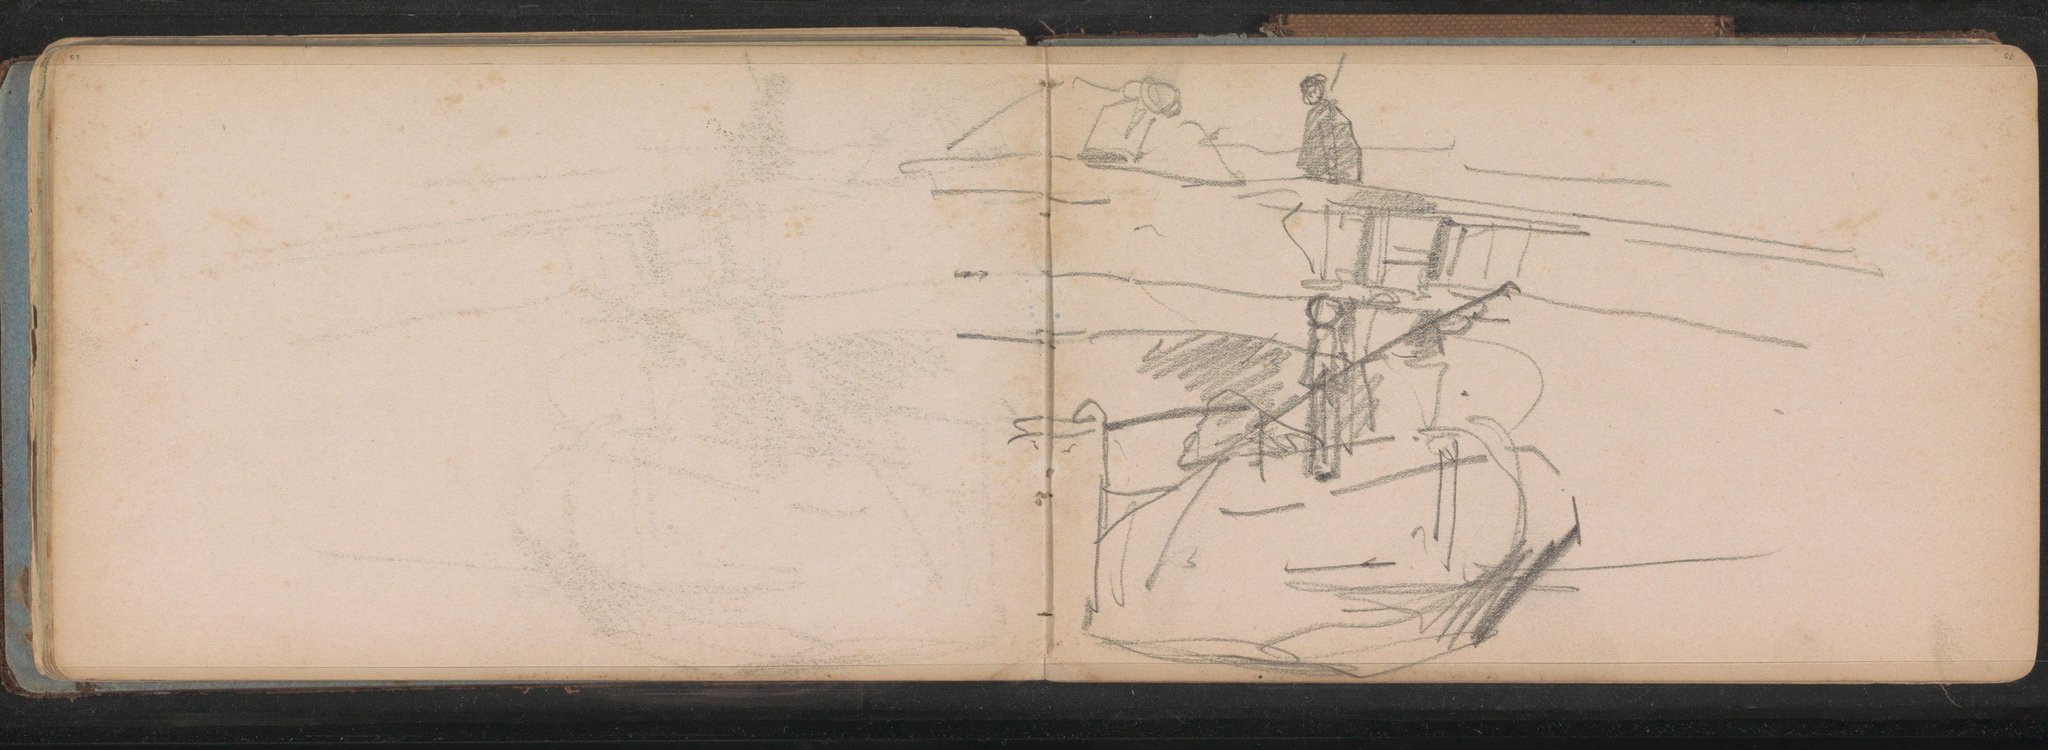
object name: sketchbook leaf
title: Figuur, mogelijk bij een schip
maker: george hendrik breitner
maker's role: draughtsman, painter, print maker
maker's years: 1857-1923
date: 1880-1882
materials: paper, pencil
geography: scheveningen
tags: adult man, ships (in general)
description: Pagina 55 en pagina 56 uit een schetsboek met 37 bladen.